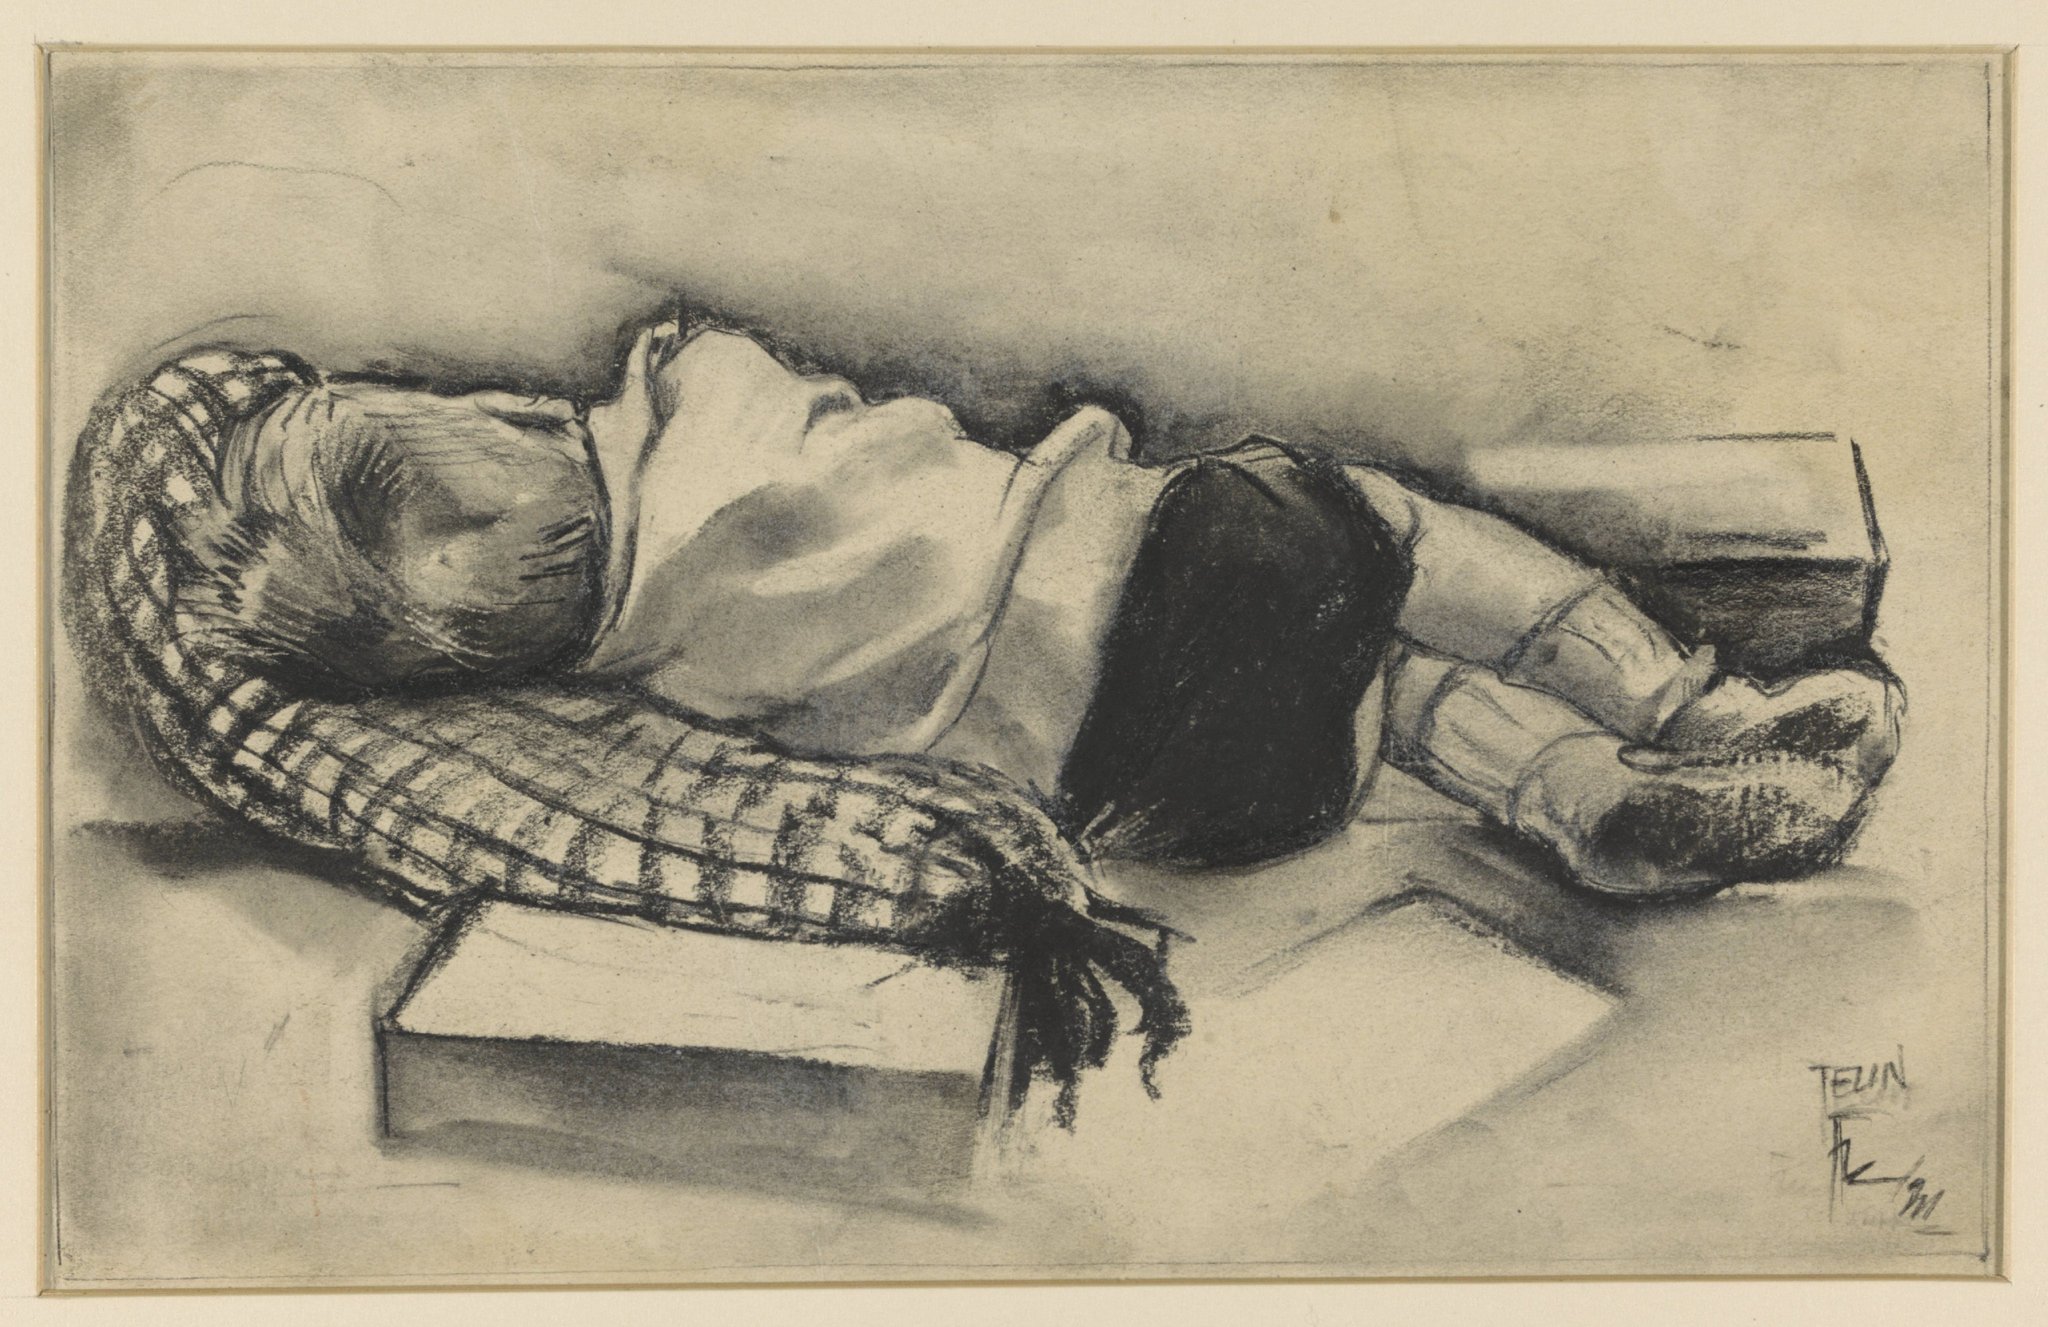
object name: drawing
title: Teun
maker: albert funke küpper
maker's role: draughtsman, print maker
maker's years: 1894-1934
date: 1904-1934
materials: chalk, charcoal, paper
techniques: scoring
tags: boy (child between toddler and youth), historical persons, sleeping; unconsciousness